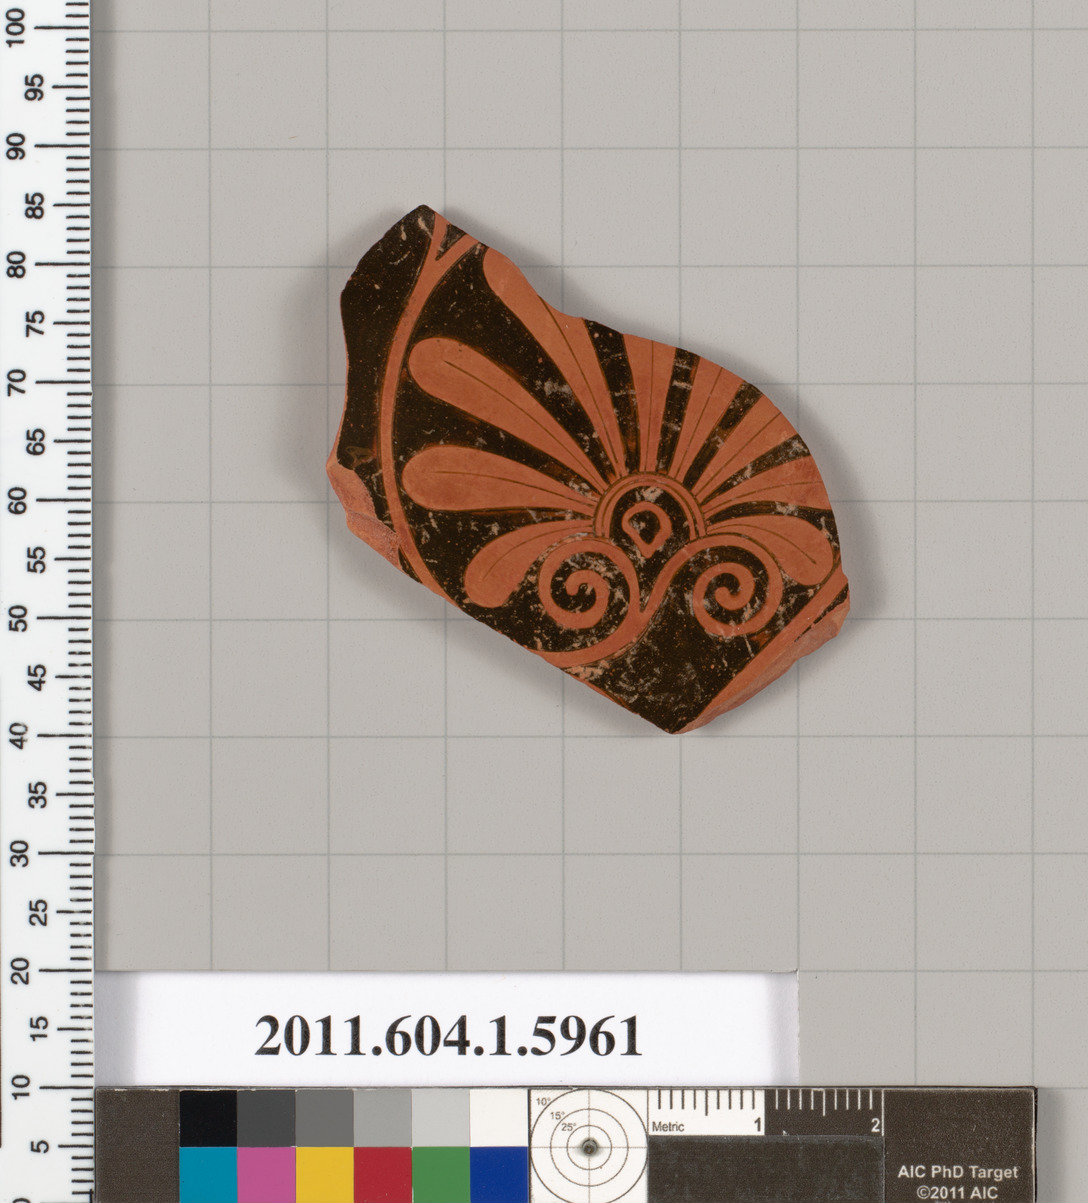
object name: kylix fragment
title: Terracotta fragment of a kylix (drinking cup)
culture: greek, attic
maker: skythes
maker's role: artist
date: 433-567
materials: terracotta